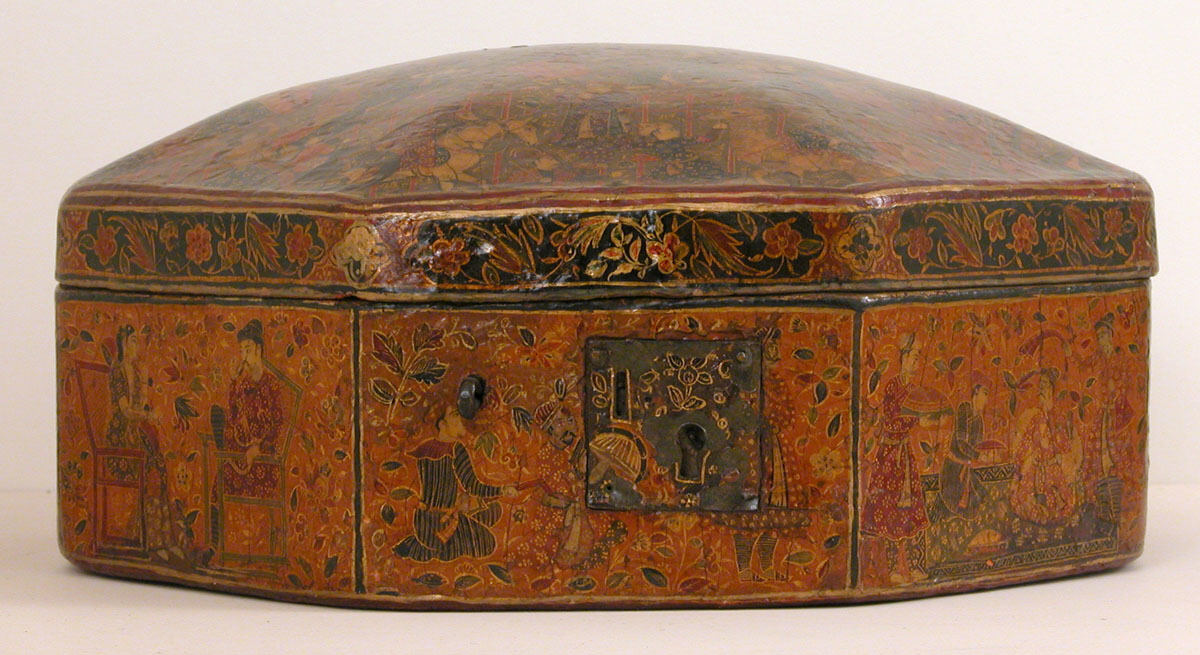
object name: box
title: Box with Scenes of an Emperor Receiving Gifts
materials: paper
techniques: lacquer, painting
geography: india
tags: men,women